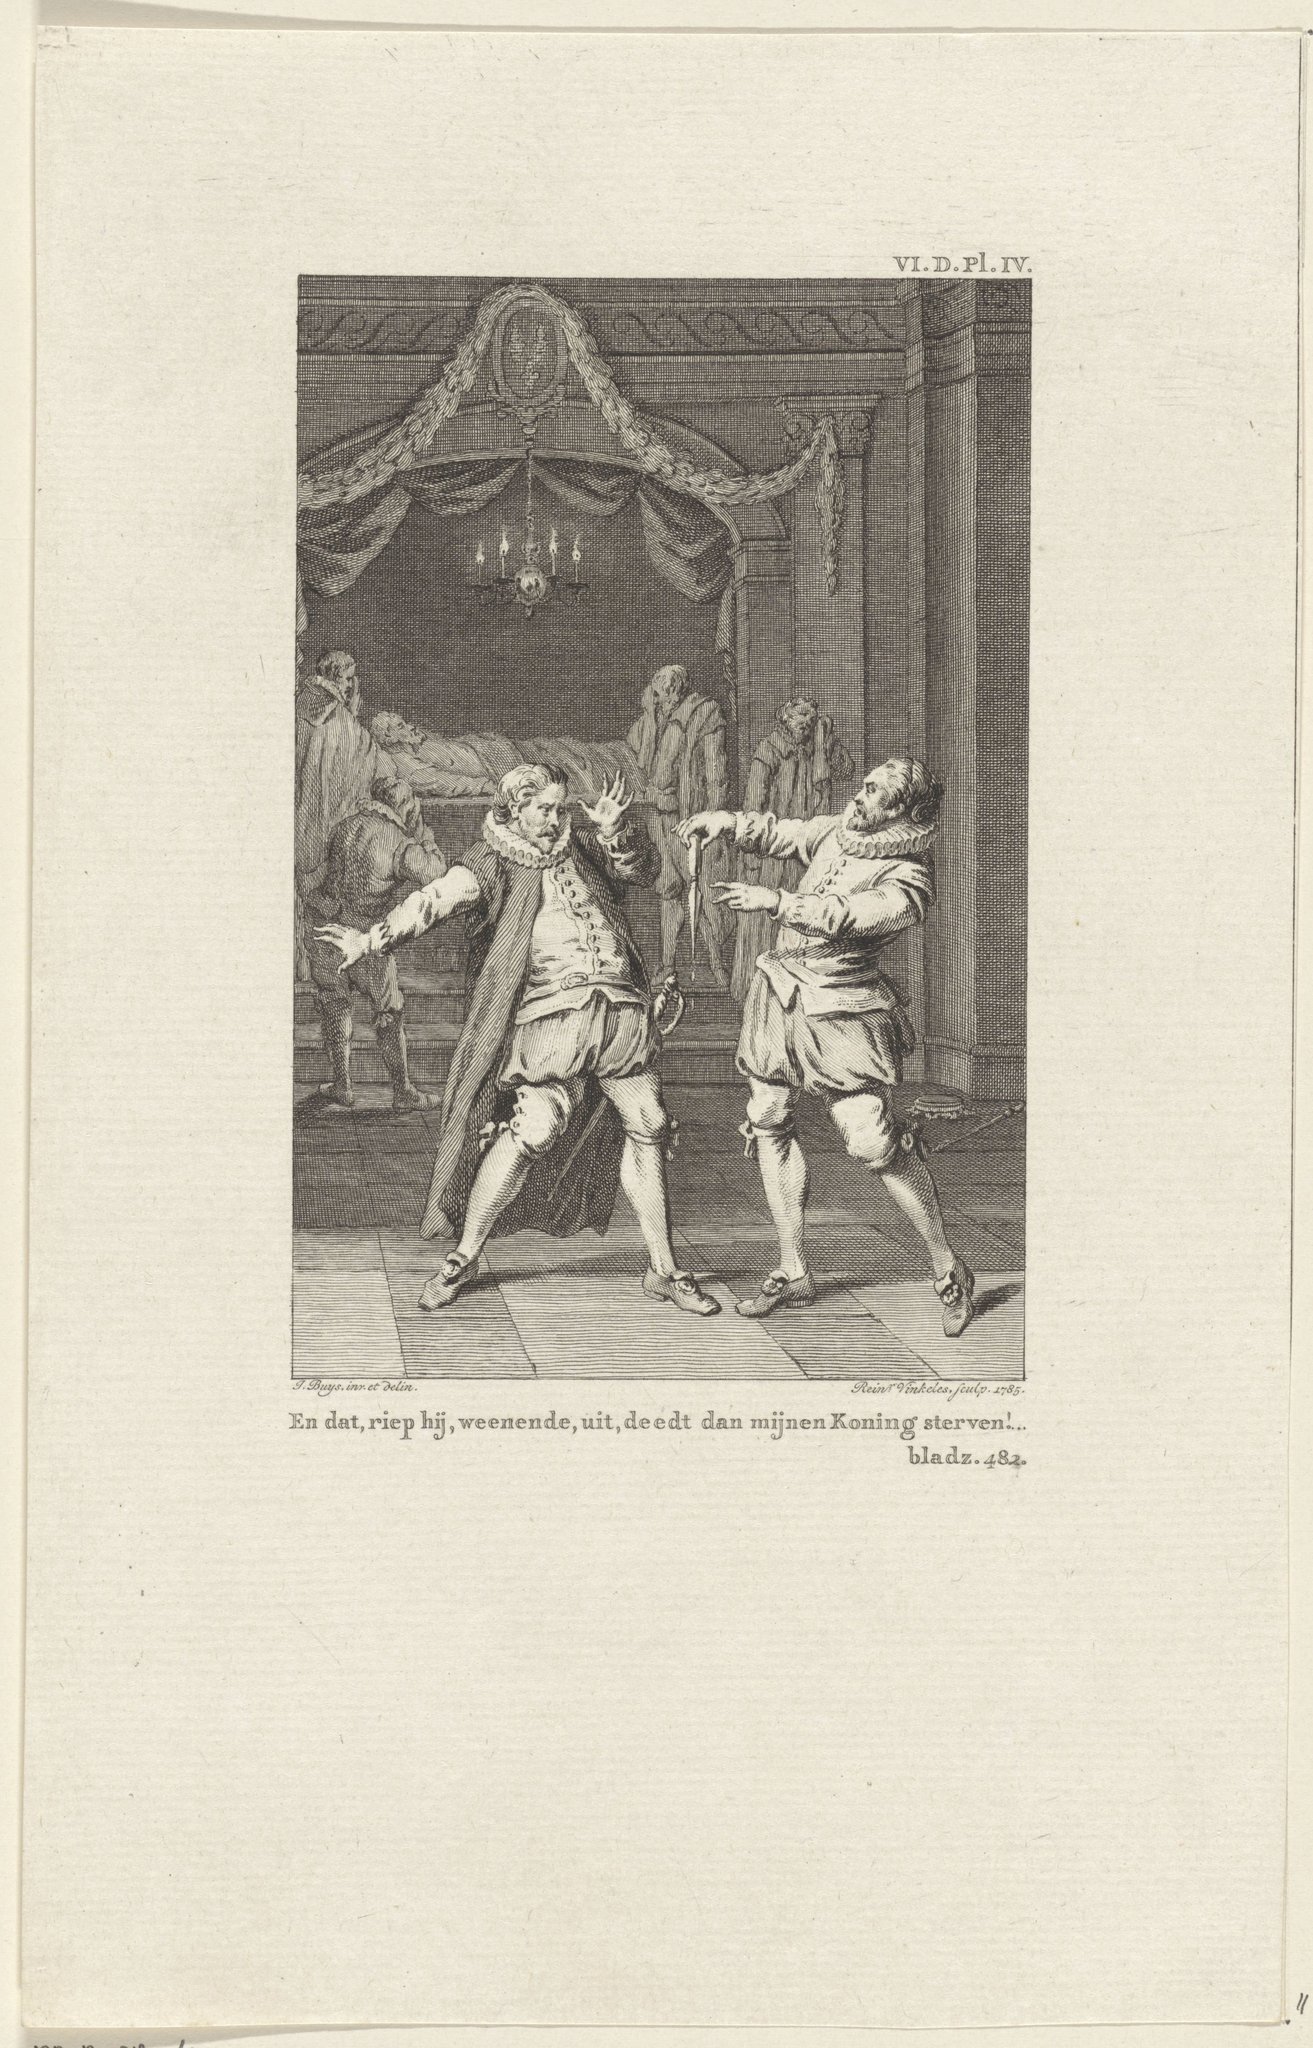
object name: book illustration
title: Hertog van Sully bij het lijk van Hendrik IV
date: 1785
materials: paper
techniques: engraving, etching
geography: amsterdam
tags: maximilien de béthune (duke of sully), hendrik iv (koning van frankrijk en navarra), vigils and wakes ~ burial rites, violent death by dagger, knife (+ variant), attempt, political murder, paris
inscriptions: collector's mark: Lugt 240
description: De hertog van Sully kijkt verschrikt naar het mes waarmee Hendrik IV werd vermoord. Op de achtergrond wordt het lichaam van Hendrik IV beweend. Rechtsboven: VI.D.Pl.IV. rechtsonder: bladz.482.